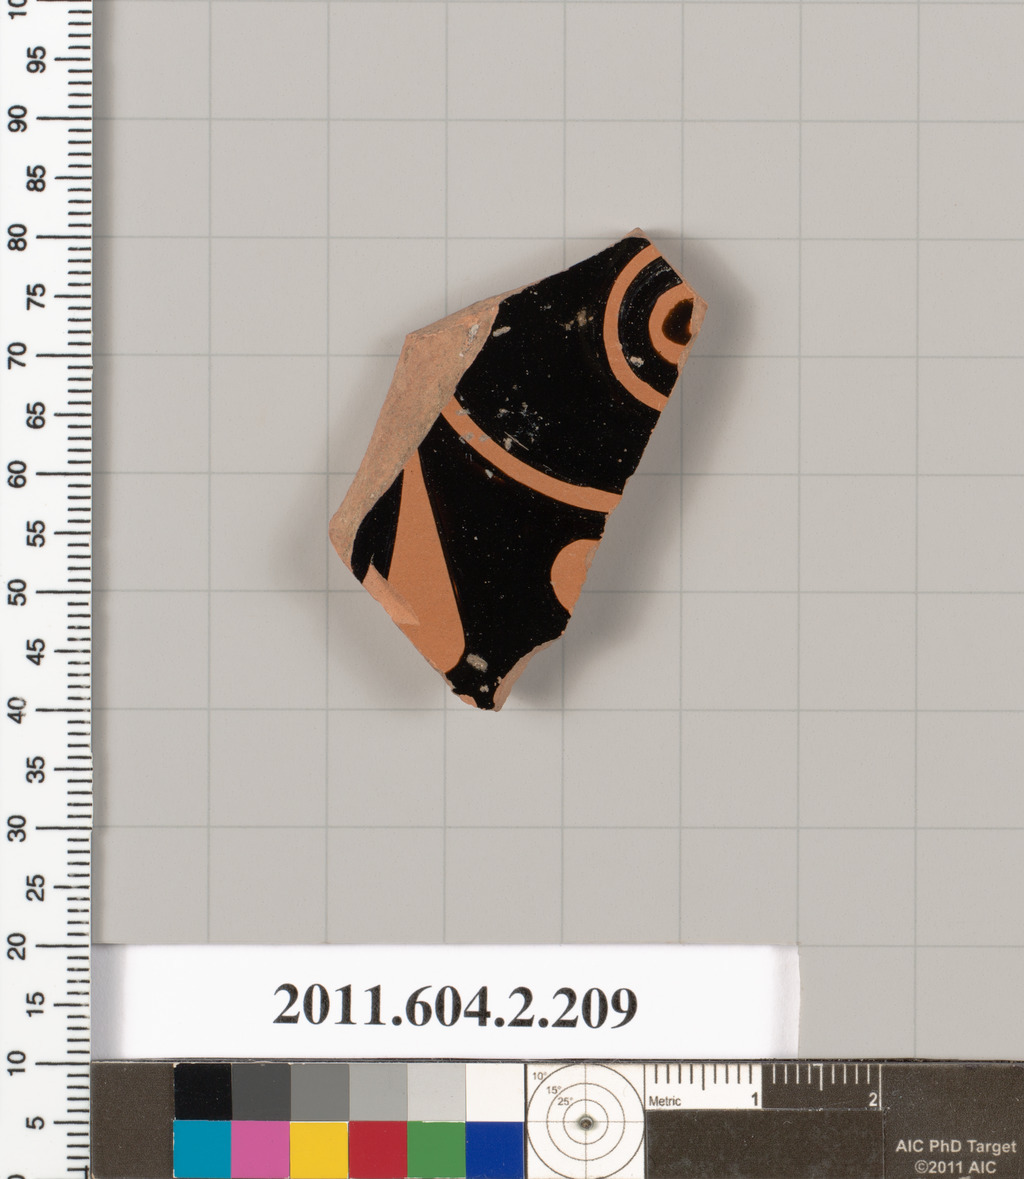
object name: stamnos fragment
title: Terracotta fragment of a stamnos (jar)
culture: greek, attic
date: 520-500 BCE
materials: terracotta